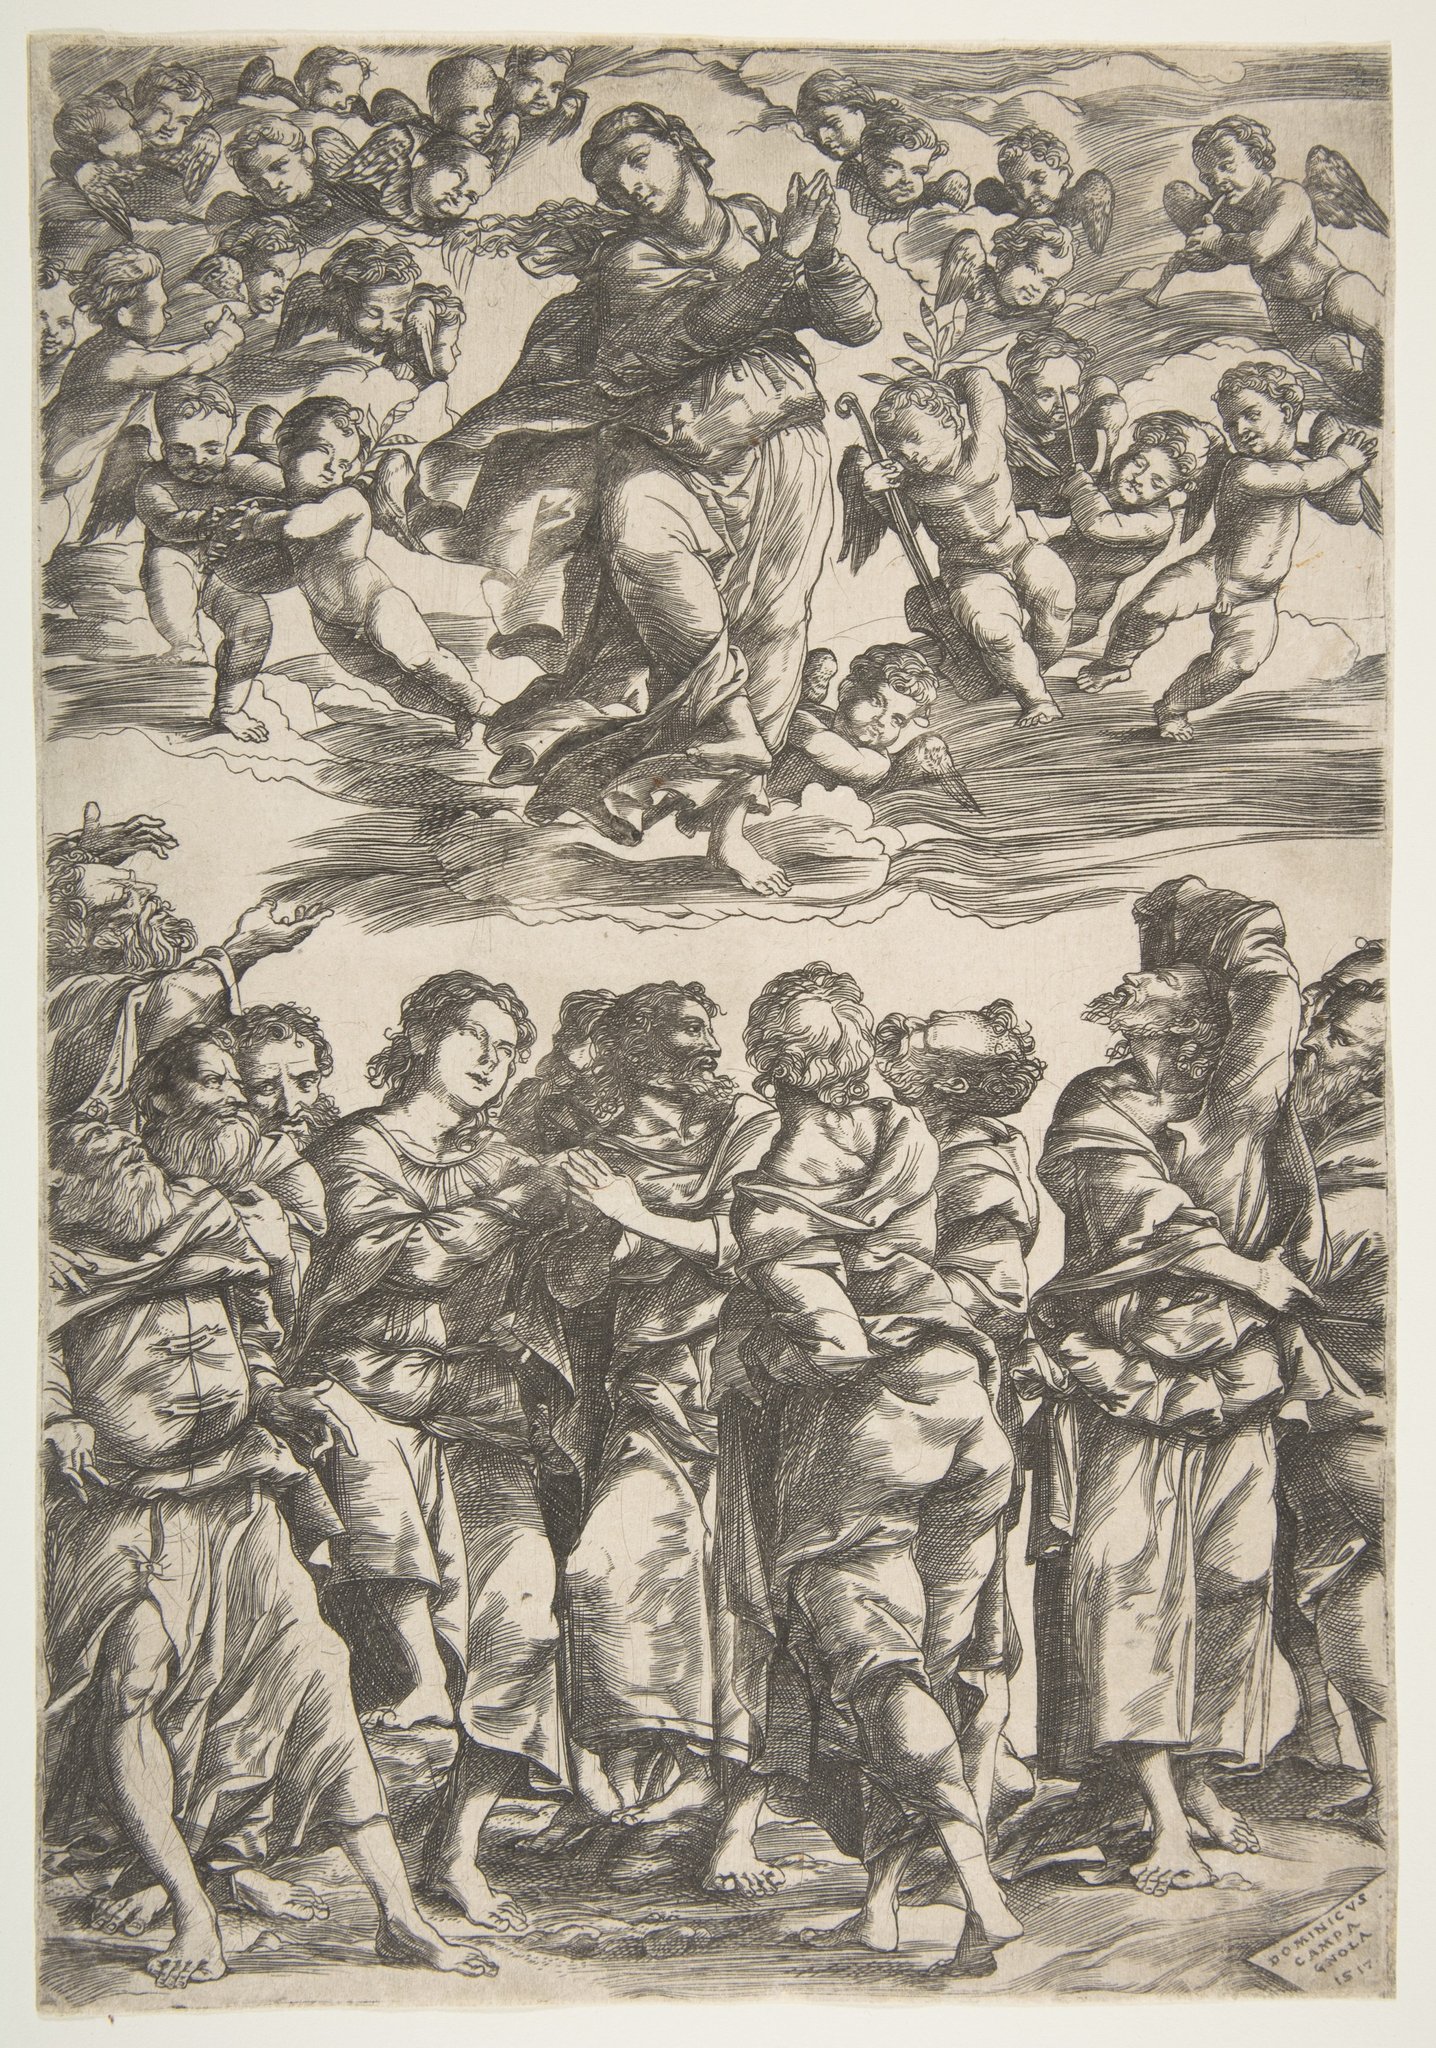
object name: print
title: The Virgin at top center in clouds with clasped hands and right foot raised, surrounded by cherubin; below, the twelve apostles stand together gesturing upwards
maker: domenico campagnola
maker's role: artist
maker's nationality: italian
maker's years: 1500-1564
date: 1517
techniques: engraving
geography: venice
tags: men,putti,angels,apostles,virgin mary